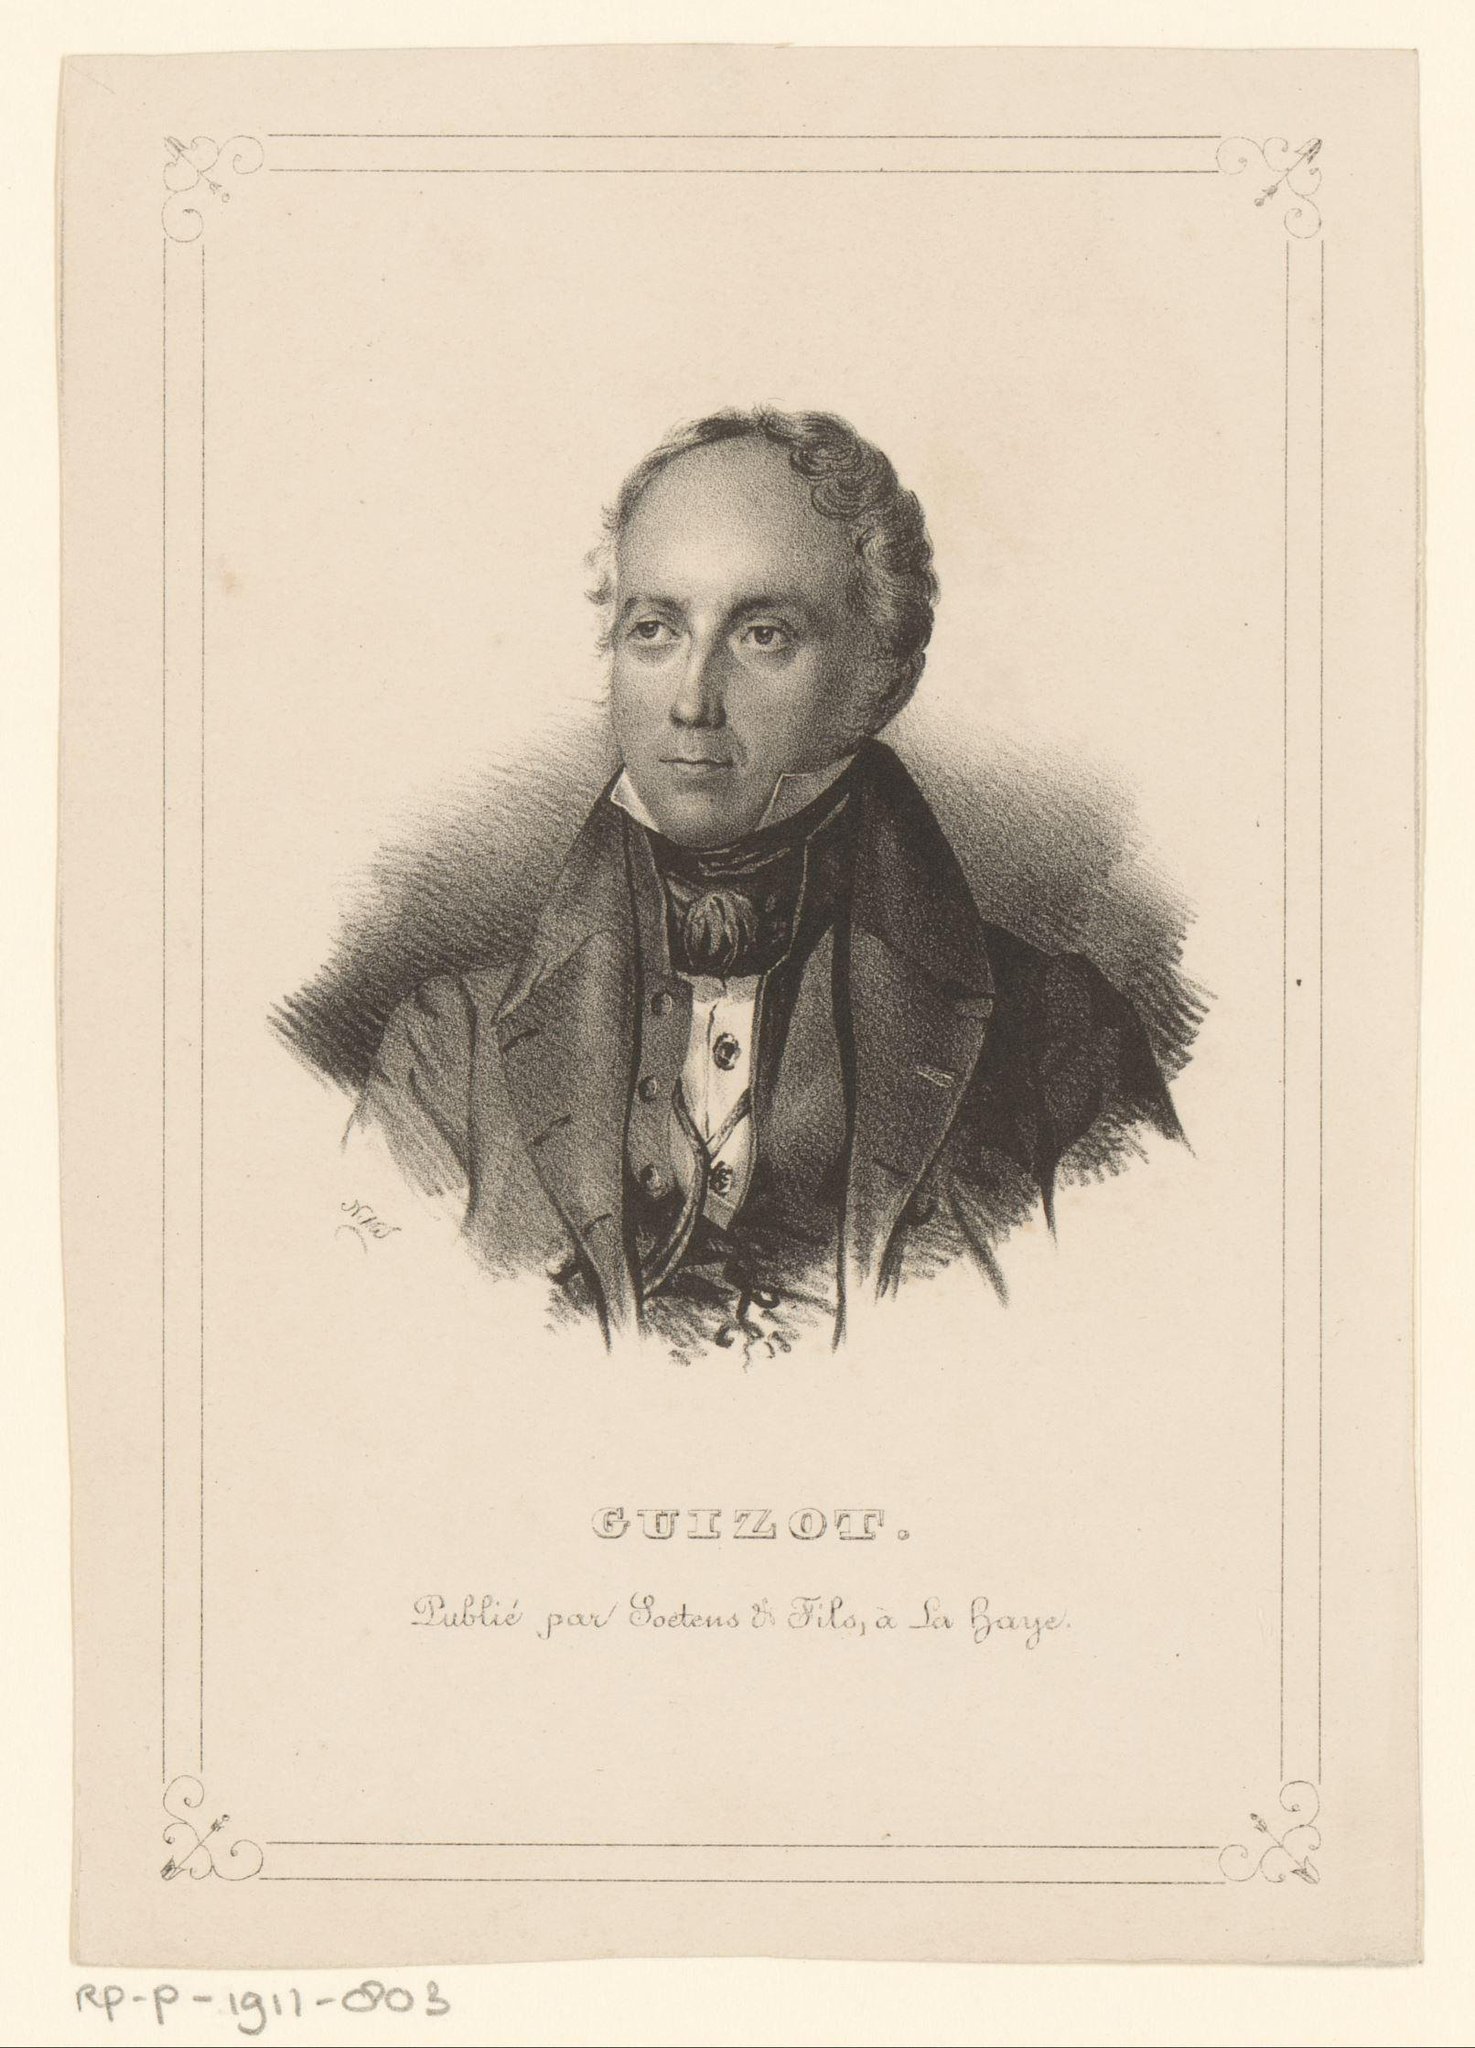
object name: print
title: Portret van François Guizot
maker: nicolaas martinus schild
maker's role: draughtsman, print maker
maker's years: 1822-1840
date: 1837-1840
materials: paper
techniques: lithograph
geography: the hague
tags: historical persons (+ (full) bust portrait)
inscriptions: collector's mark: Lugt 2228